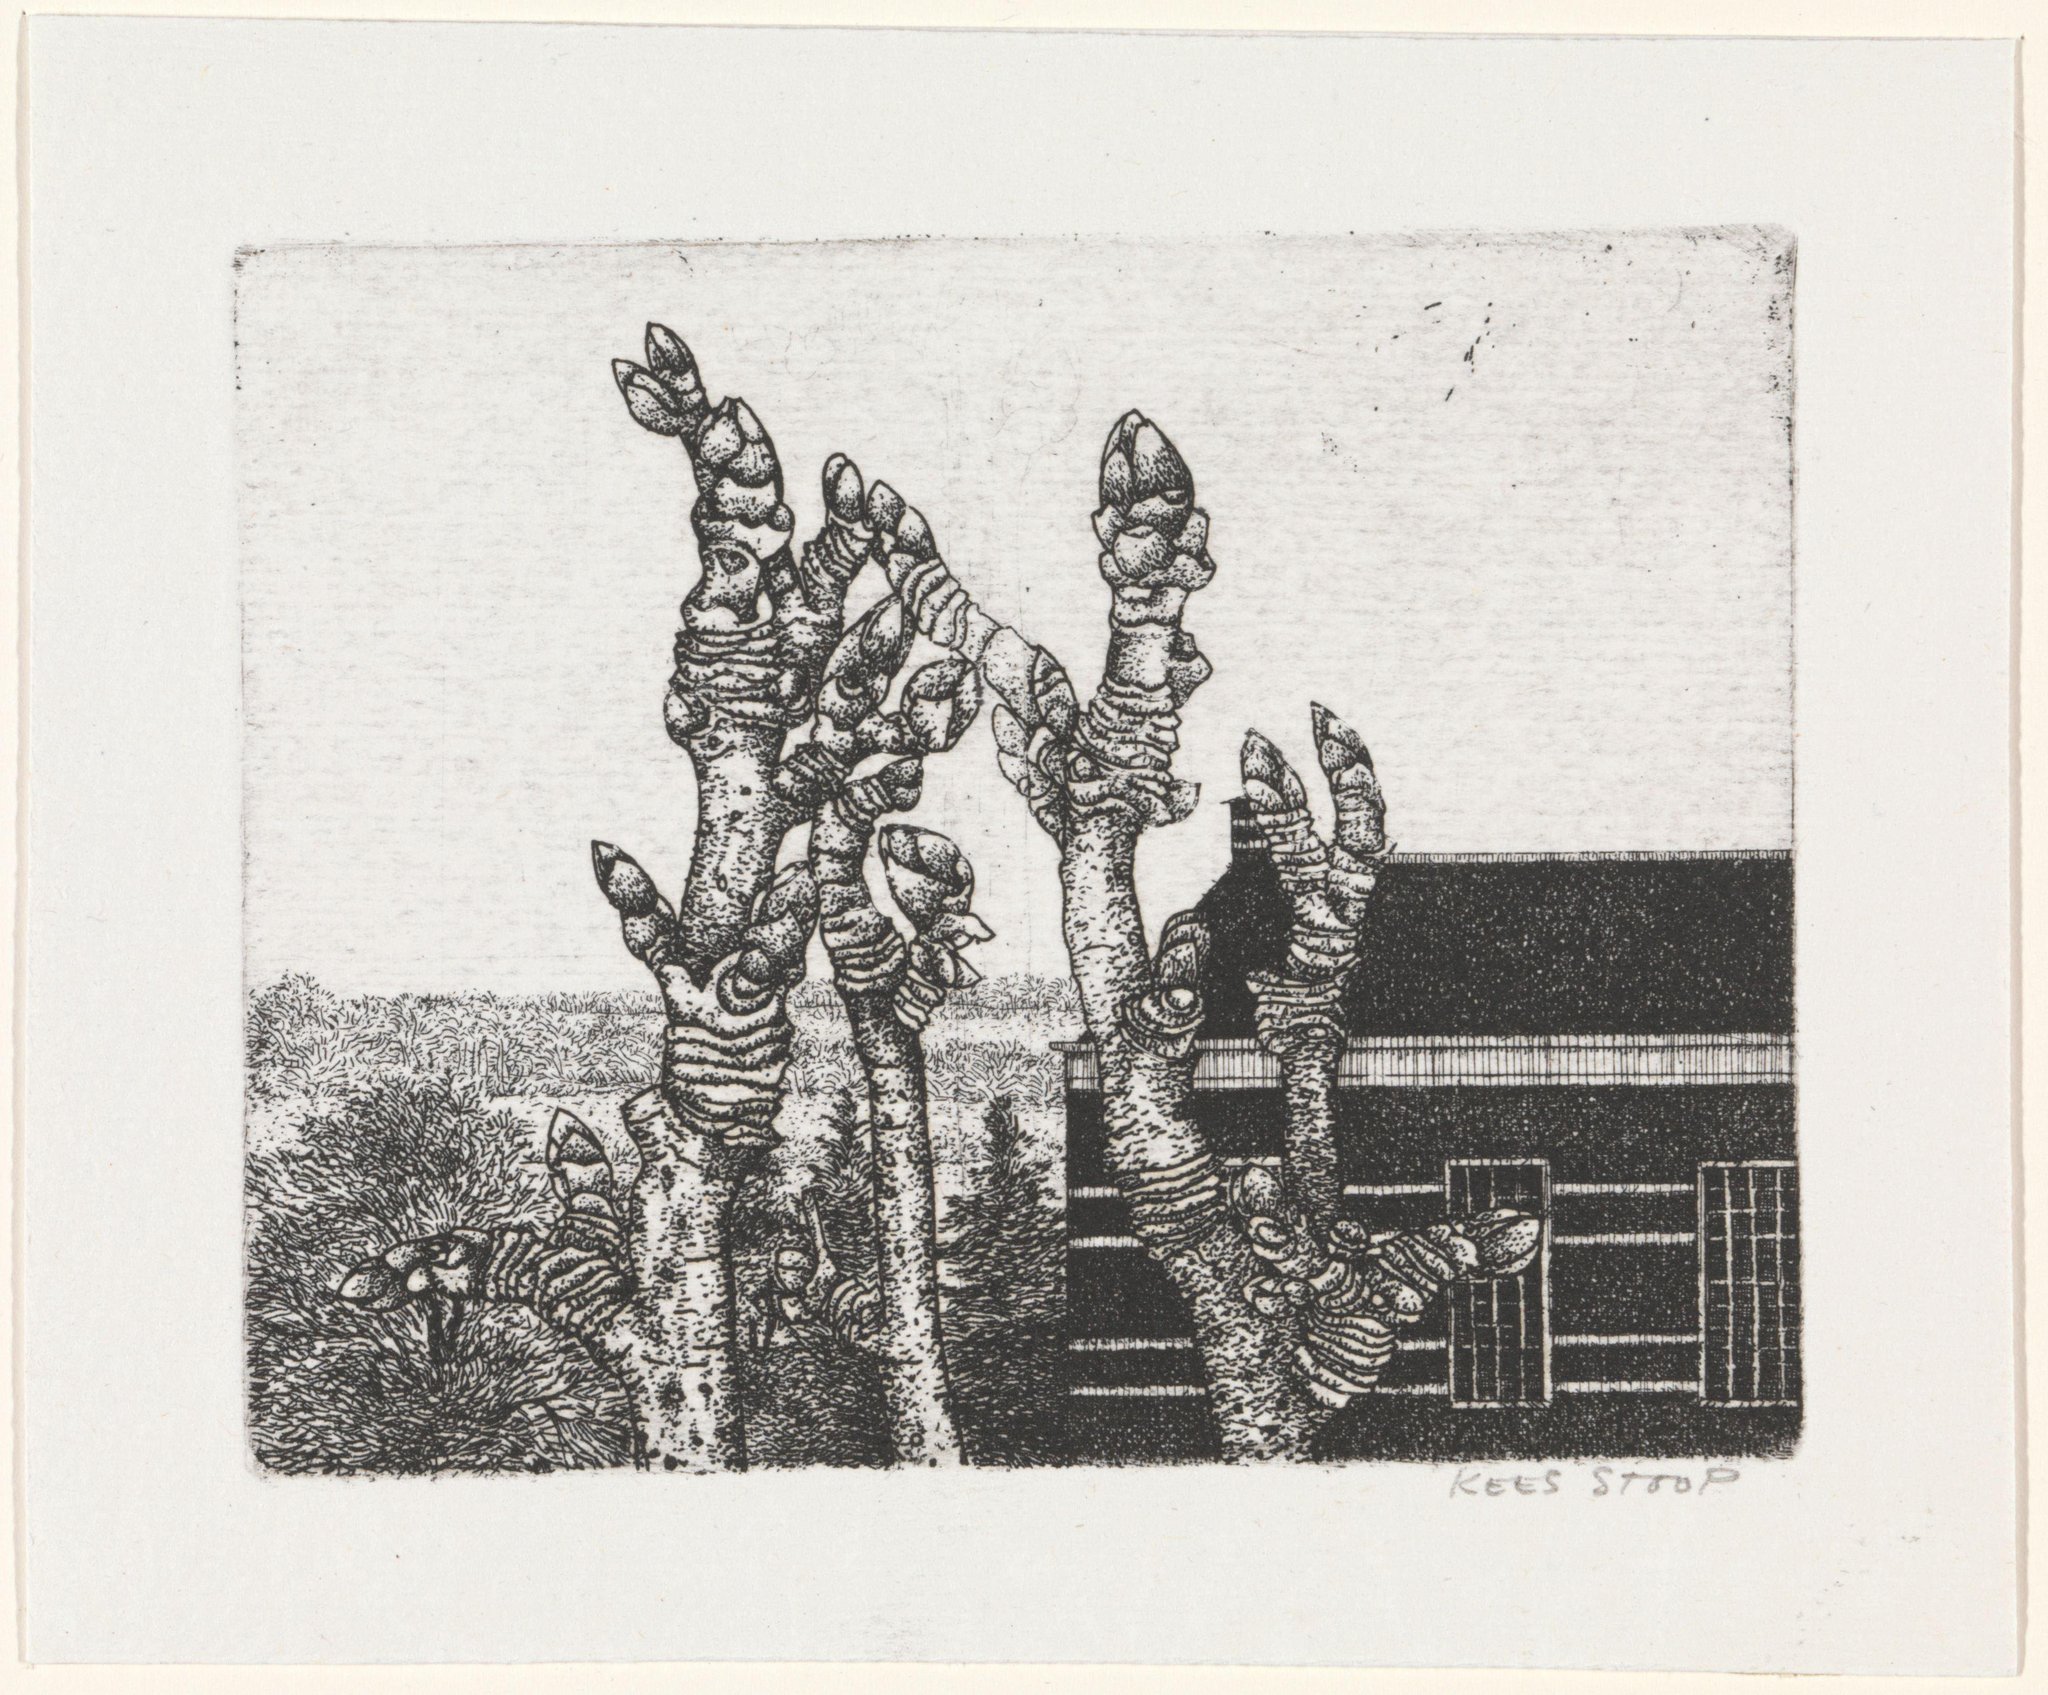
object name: print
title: Boomknoppen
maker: kees stoop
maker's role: draughtsman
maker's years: 1929-2019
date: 1975-1977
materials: paper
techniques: etching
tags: trees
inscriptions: inscription: ‘gekocht bij ons eerste bezoek / 2 Aug. 1977 / IN: 75/76?’, signature: ‘KEES STOOP’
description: Boomknoppen op de voorgrond, op de achtergrond een huis.